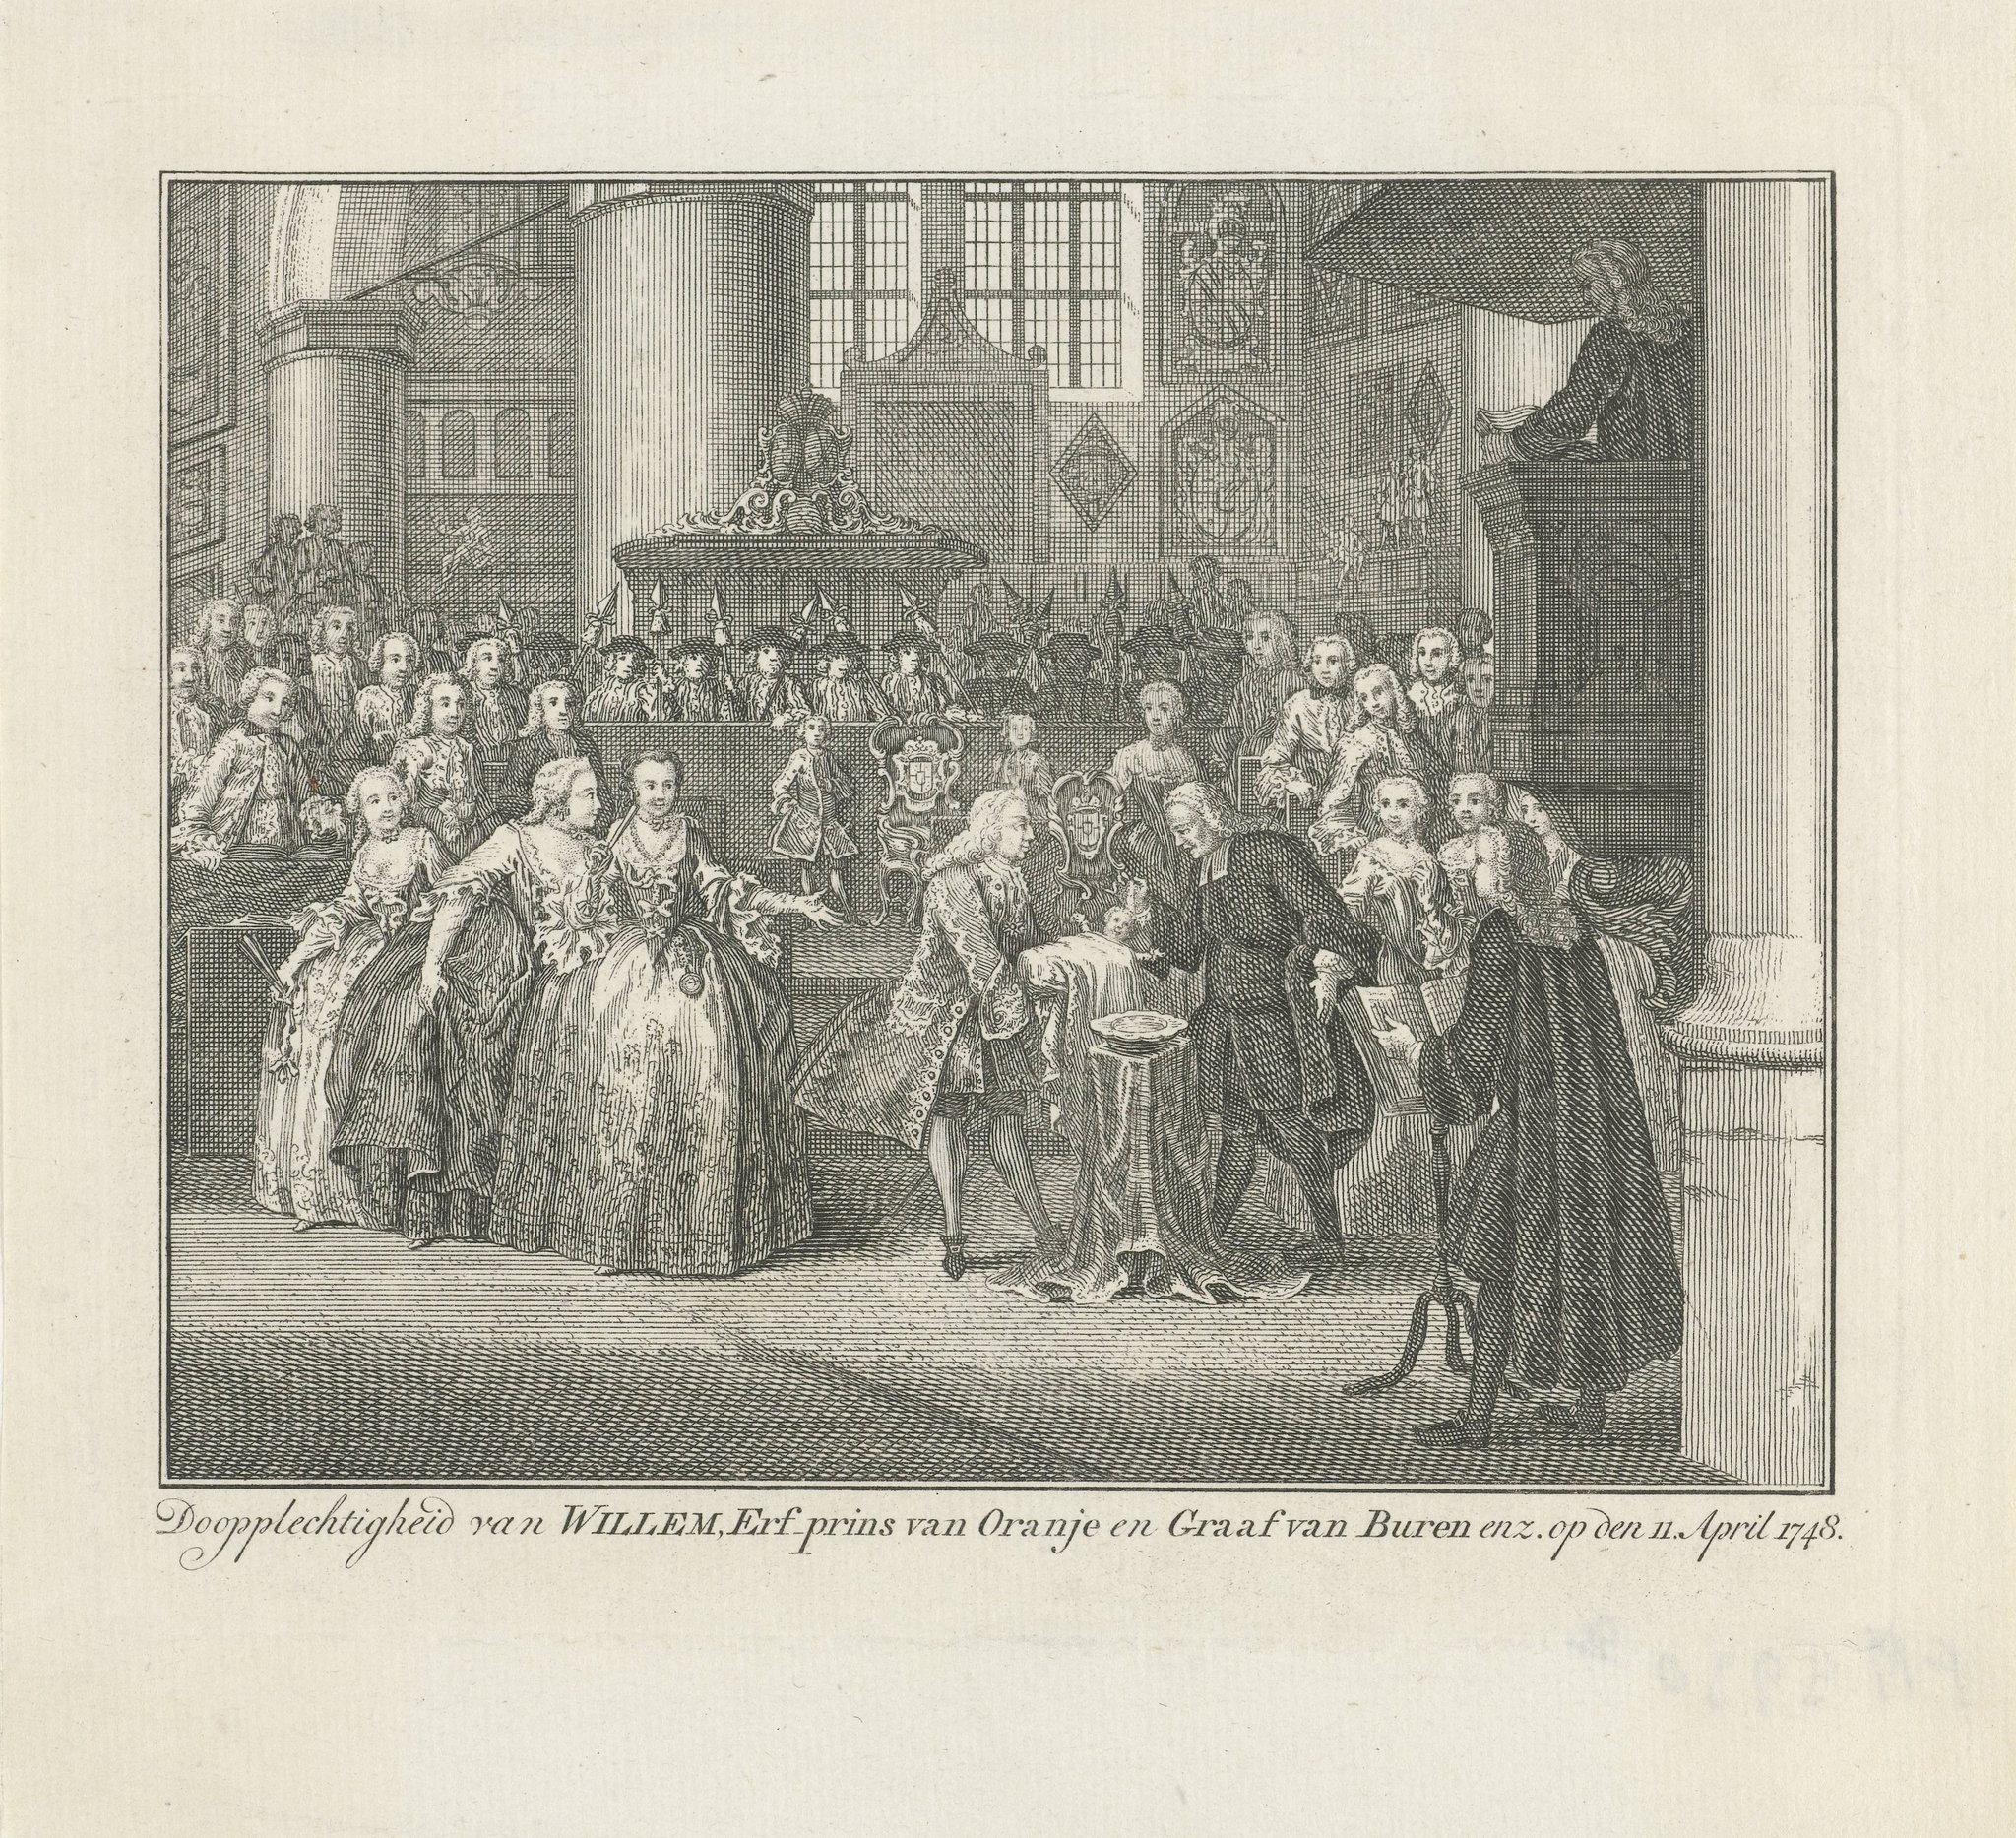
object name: print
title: Doopplechtigheid van Willem, Erf-prins van Oranje en Graaf van Buren enz. op den 11 April 1748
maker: gerard sibelius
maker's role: print maker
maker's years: 1734-1785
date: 1750-1752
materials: paper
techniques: engraving, etching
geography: northern netherlands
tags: william v (prince of orange), willem iv (prins van oranje-nassau), anna van hannover, baptism ~ protestant service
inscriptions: collector's mark: Lugt 2228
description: Gebruikt als illustratie in: J.L. Schuer, Nederlands merkwaardigste gebeurtenissen sedert byna twee eeuwen. Amsterdam: Steven van Esveldt, 1752. Kopie naar de prent van Simon Fokke uit 1748, FMH 3929a.